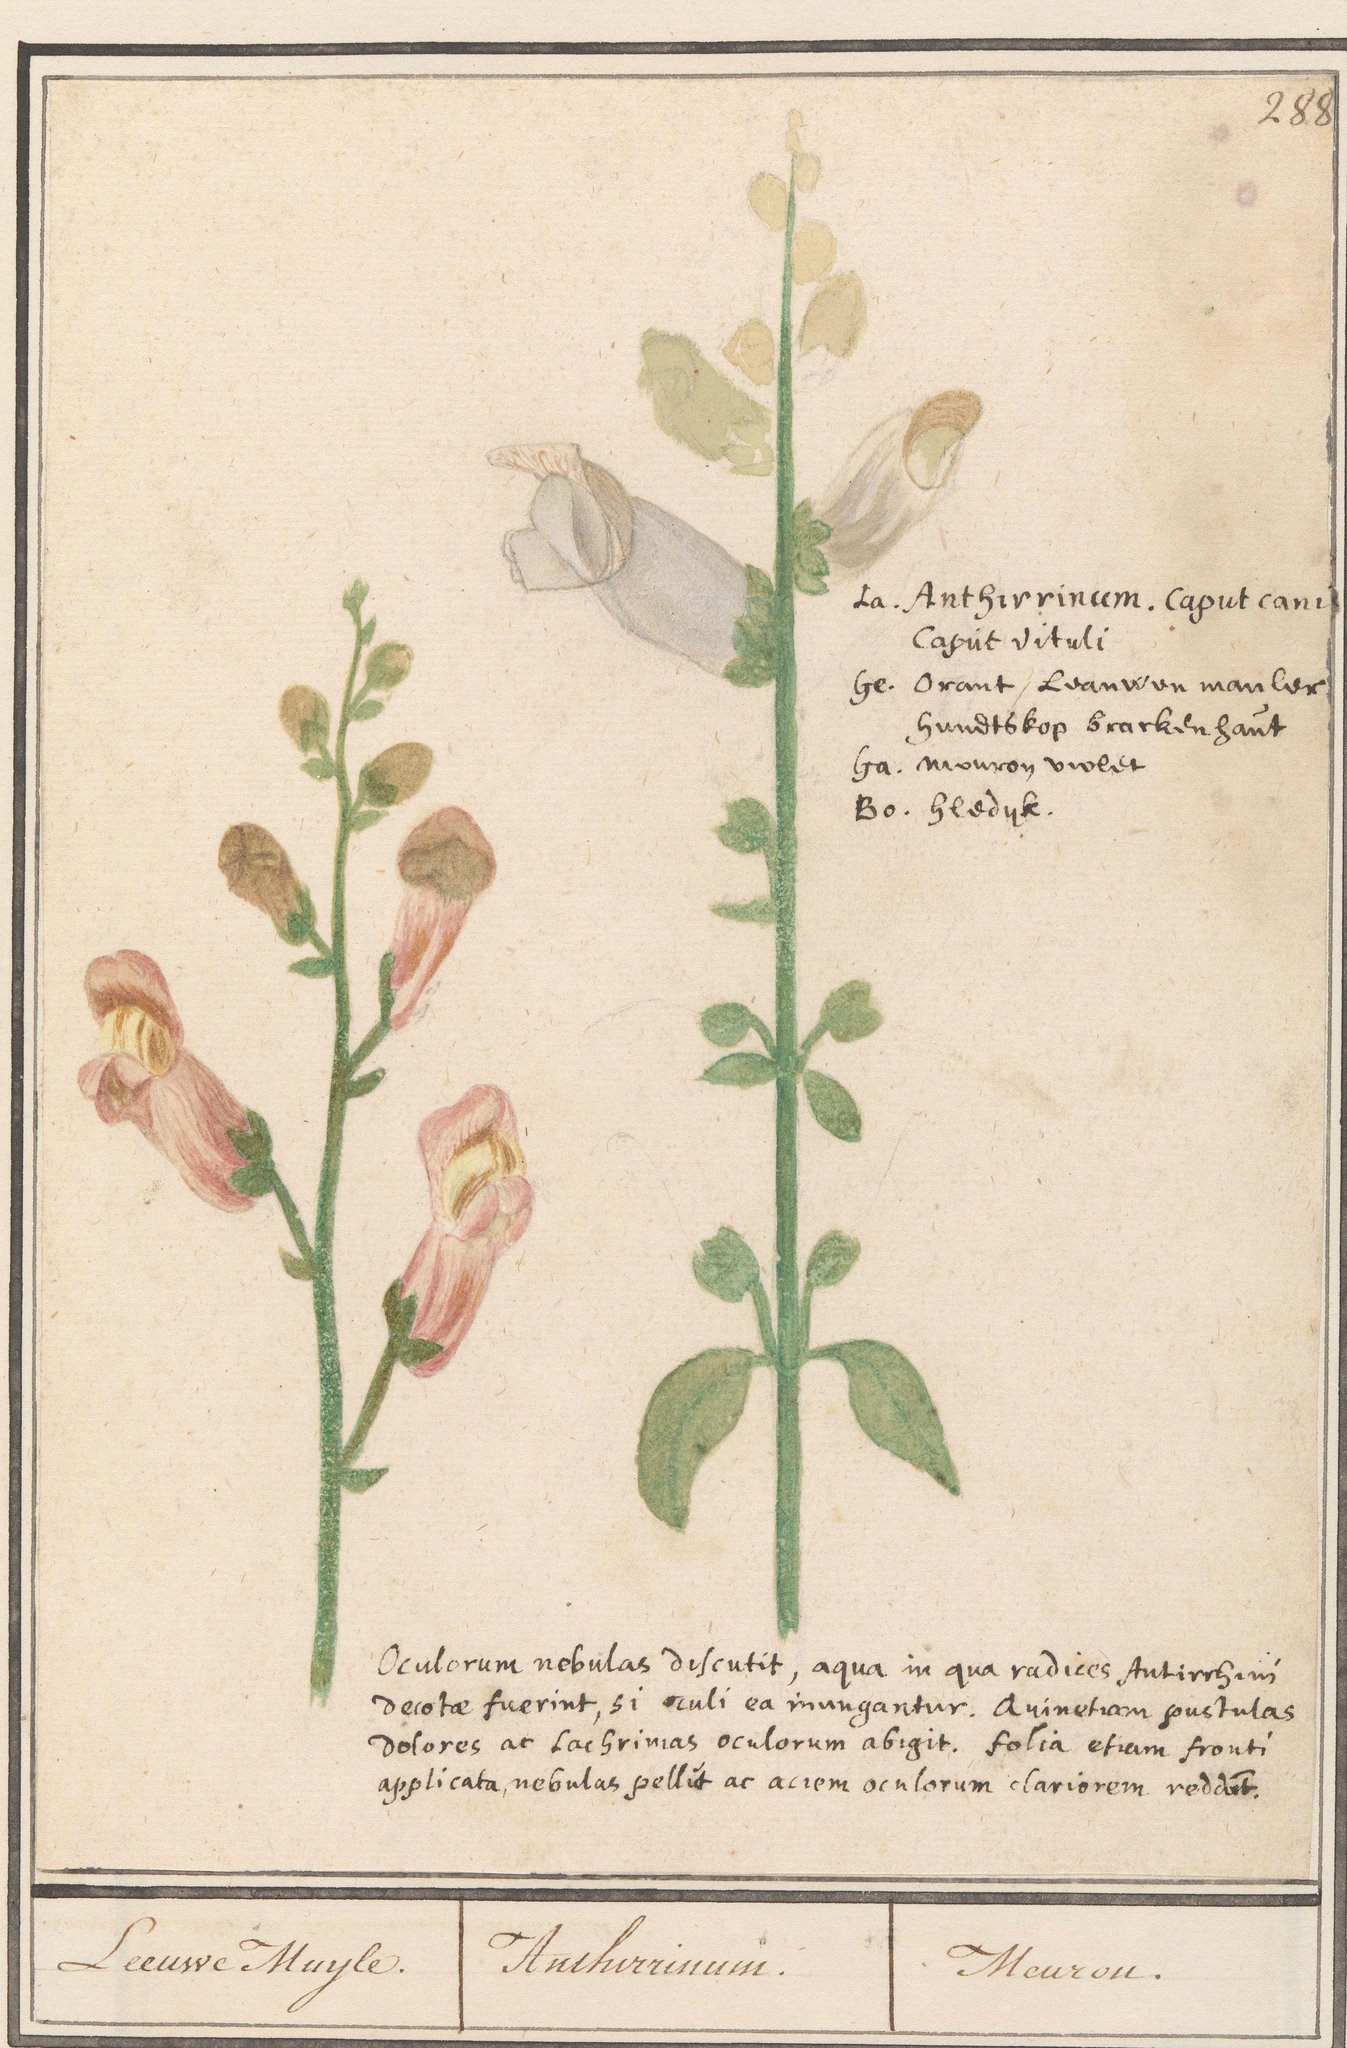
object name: drawing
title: Leeuwe Muyle. / Anthirrinum. / Meuron.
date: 1596-1610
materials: chalk, paint, ink, paper, watercolor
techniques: brush, pen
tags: flowers: snapdragon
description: Leeuwenbek. Genummerd rechtsboven: 288. Linksboven de naam in vier talen, onderaan een vierregelig opschrift in het Latijn. Onderdeel van het derde album met tekeningen van bloemen en planten. Tiende van twaalf albums met tekeningen van dieren, vogels en planten bekend rond 1600, gemaakt in opdracht van keizer Rudolf II. Met toelichting in Nederlands, Latijn en Frans.